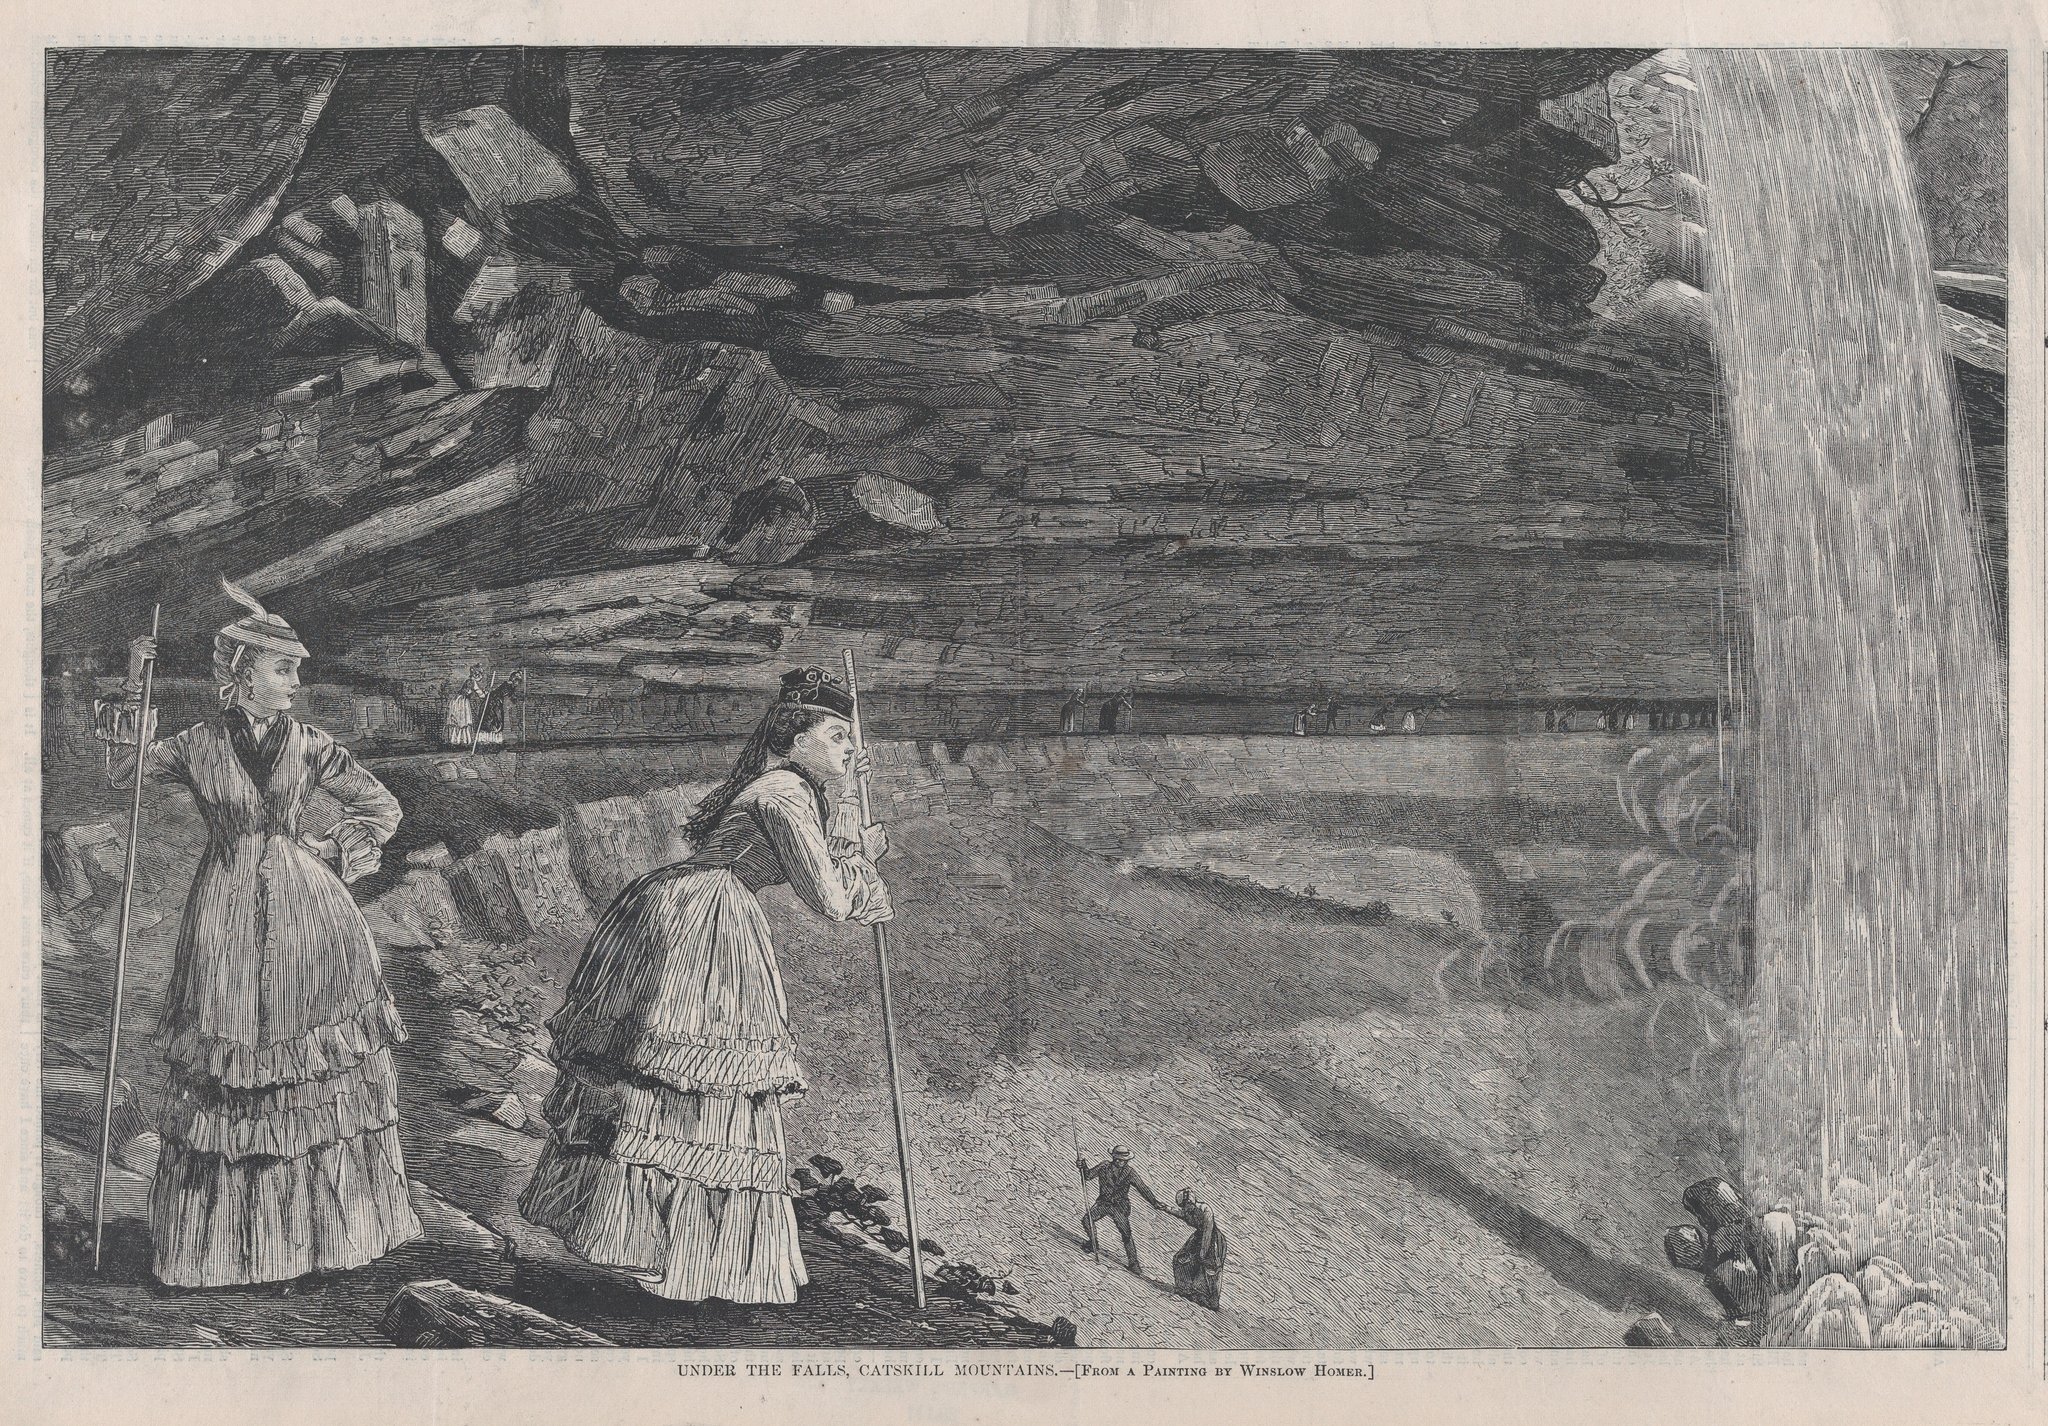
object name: print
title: Under the Falls, Catskill Mountains, from "Harper's Weekly," Vol. XVI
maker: winslow homer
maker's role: artist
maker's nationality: american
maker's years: 1836-1910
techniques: engraving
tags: women,waterfalls,caves